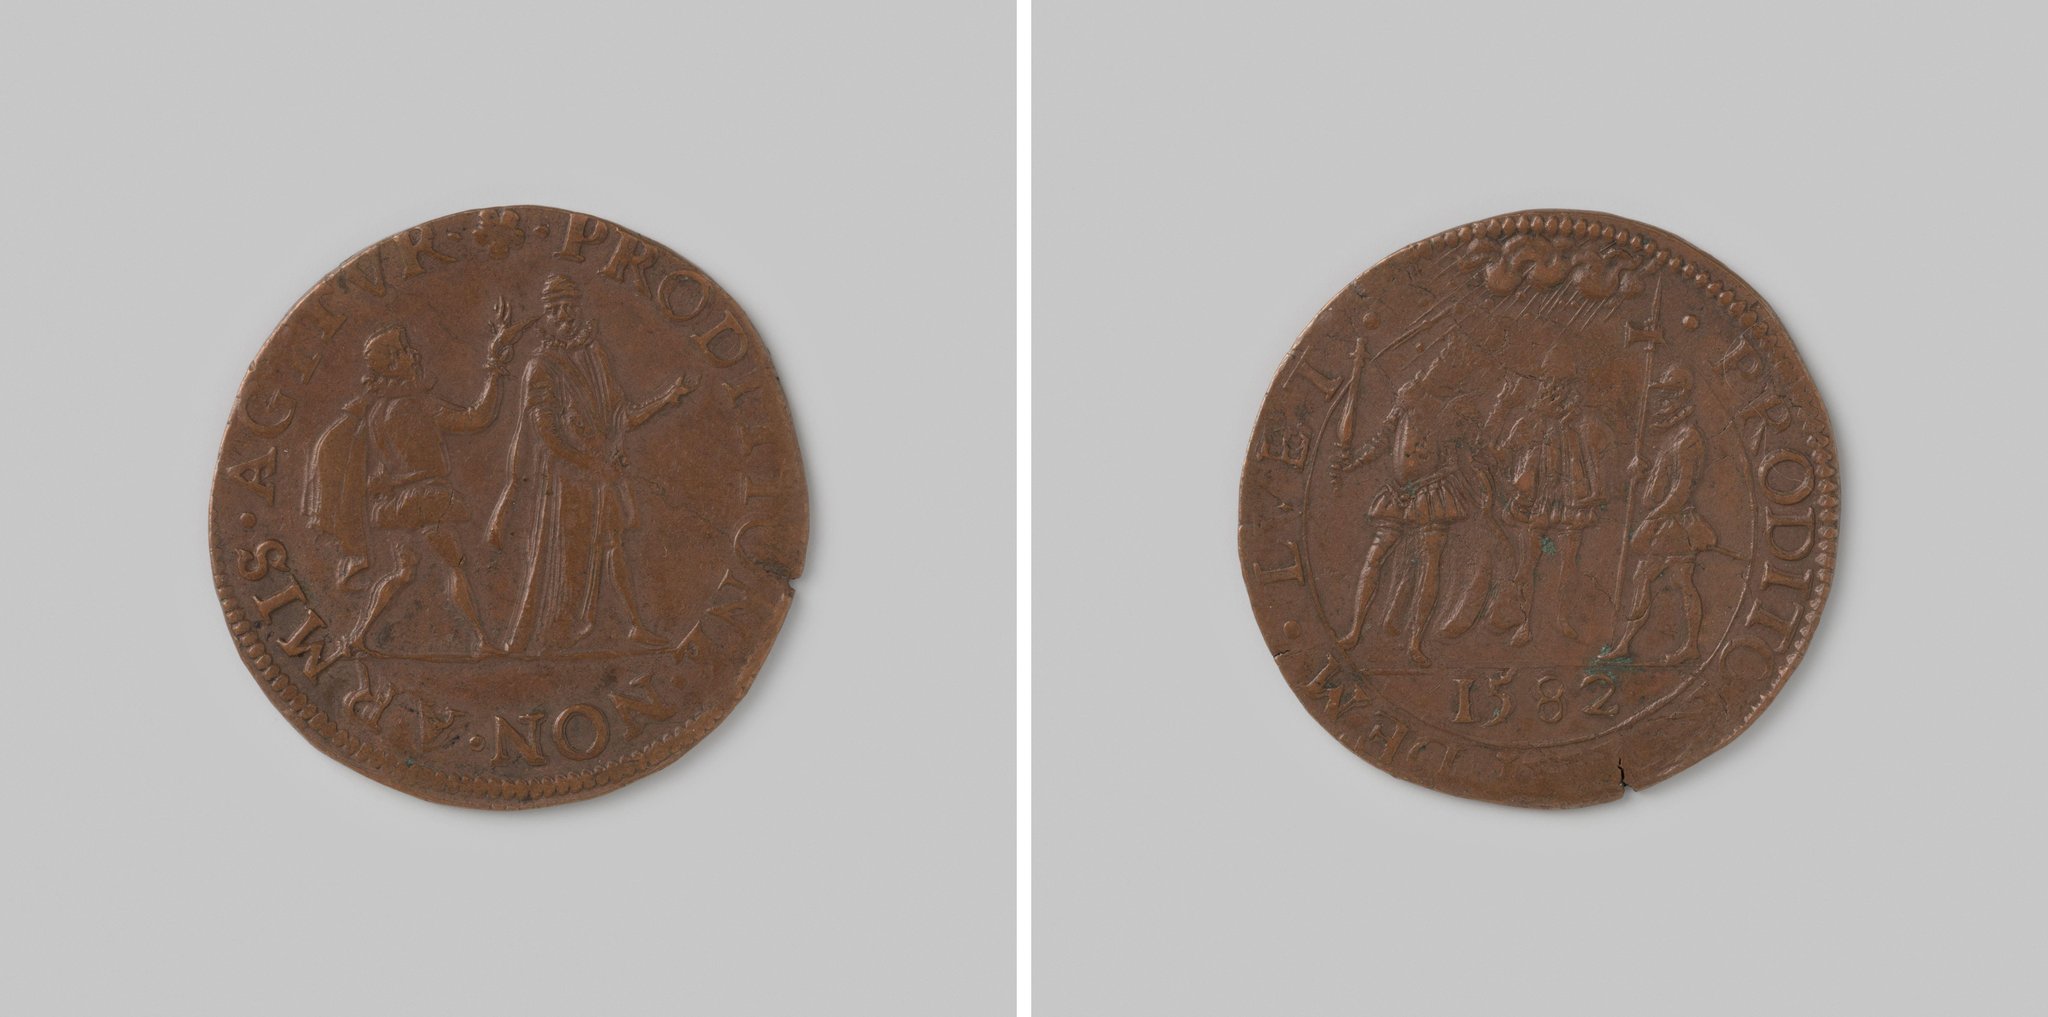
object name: history medal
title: Rekenpenning uit Dordrecht op de aanslag op Willem van Oranje door Jean Jauregui 1582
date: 1582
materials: copper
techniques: striking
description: Koperen penning, op de voorzijde Jauregui die op Willem van Oranje schiet, met omschrift, op de keerzijde Koning Philips II van Spanje stampvoetend en door een hagelbui geteisterd, naast een raadsheer en een soldaat, met omschrift en afsnedetekst.